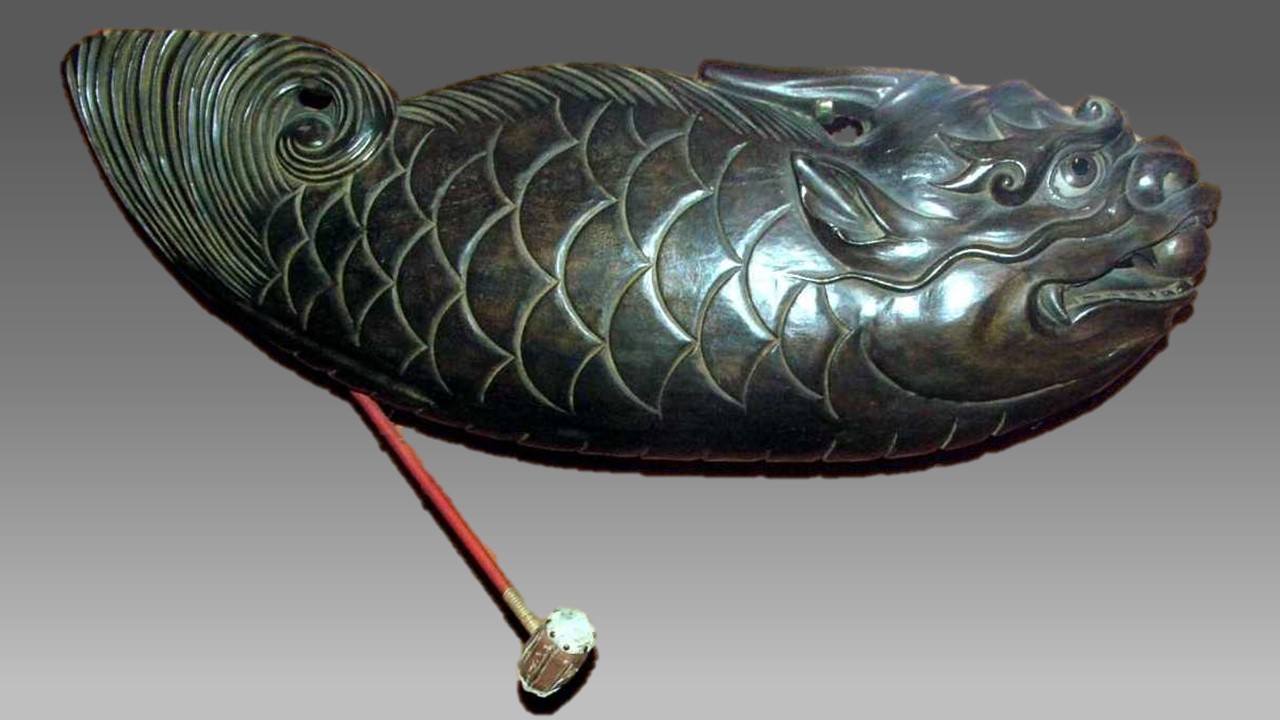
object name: mokugyo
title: Mokugyo (木魚)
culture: japanese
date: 1800-1889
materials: wood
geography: japan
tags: fish